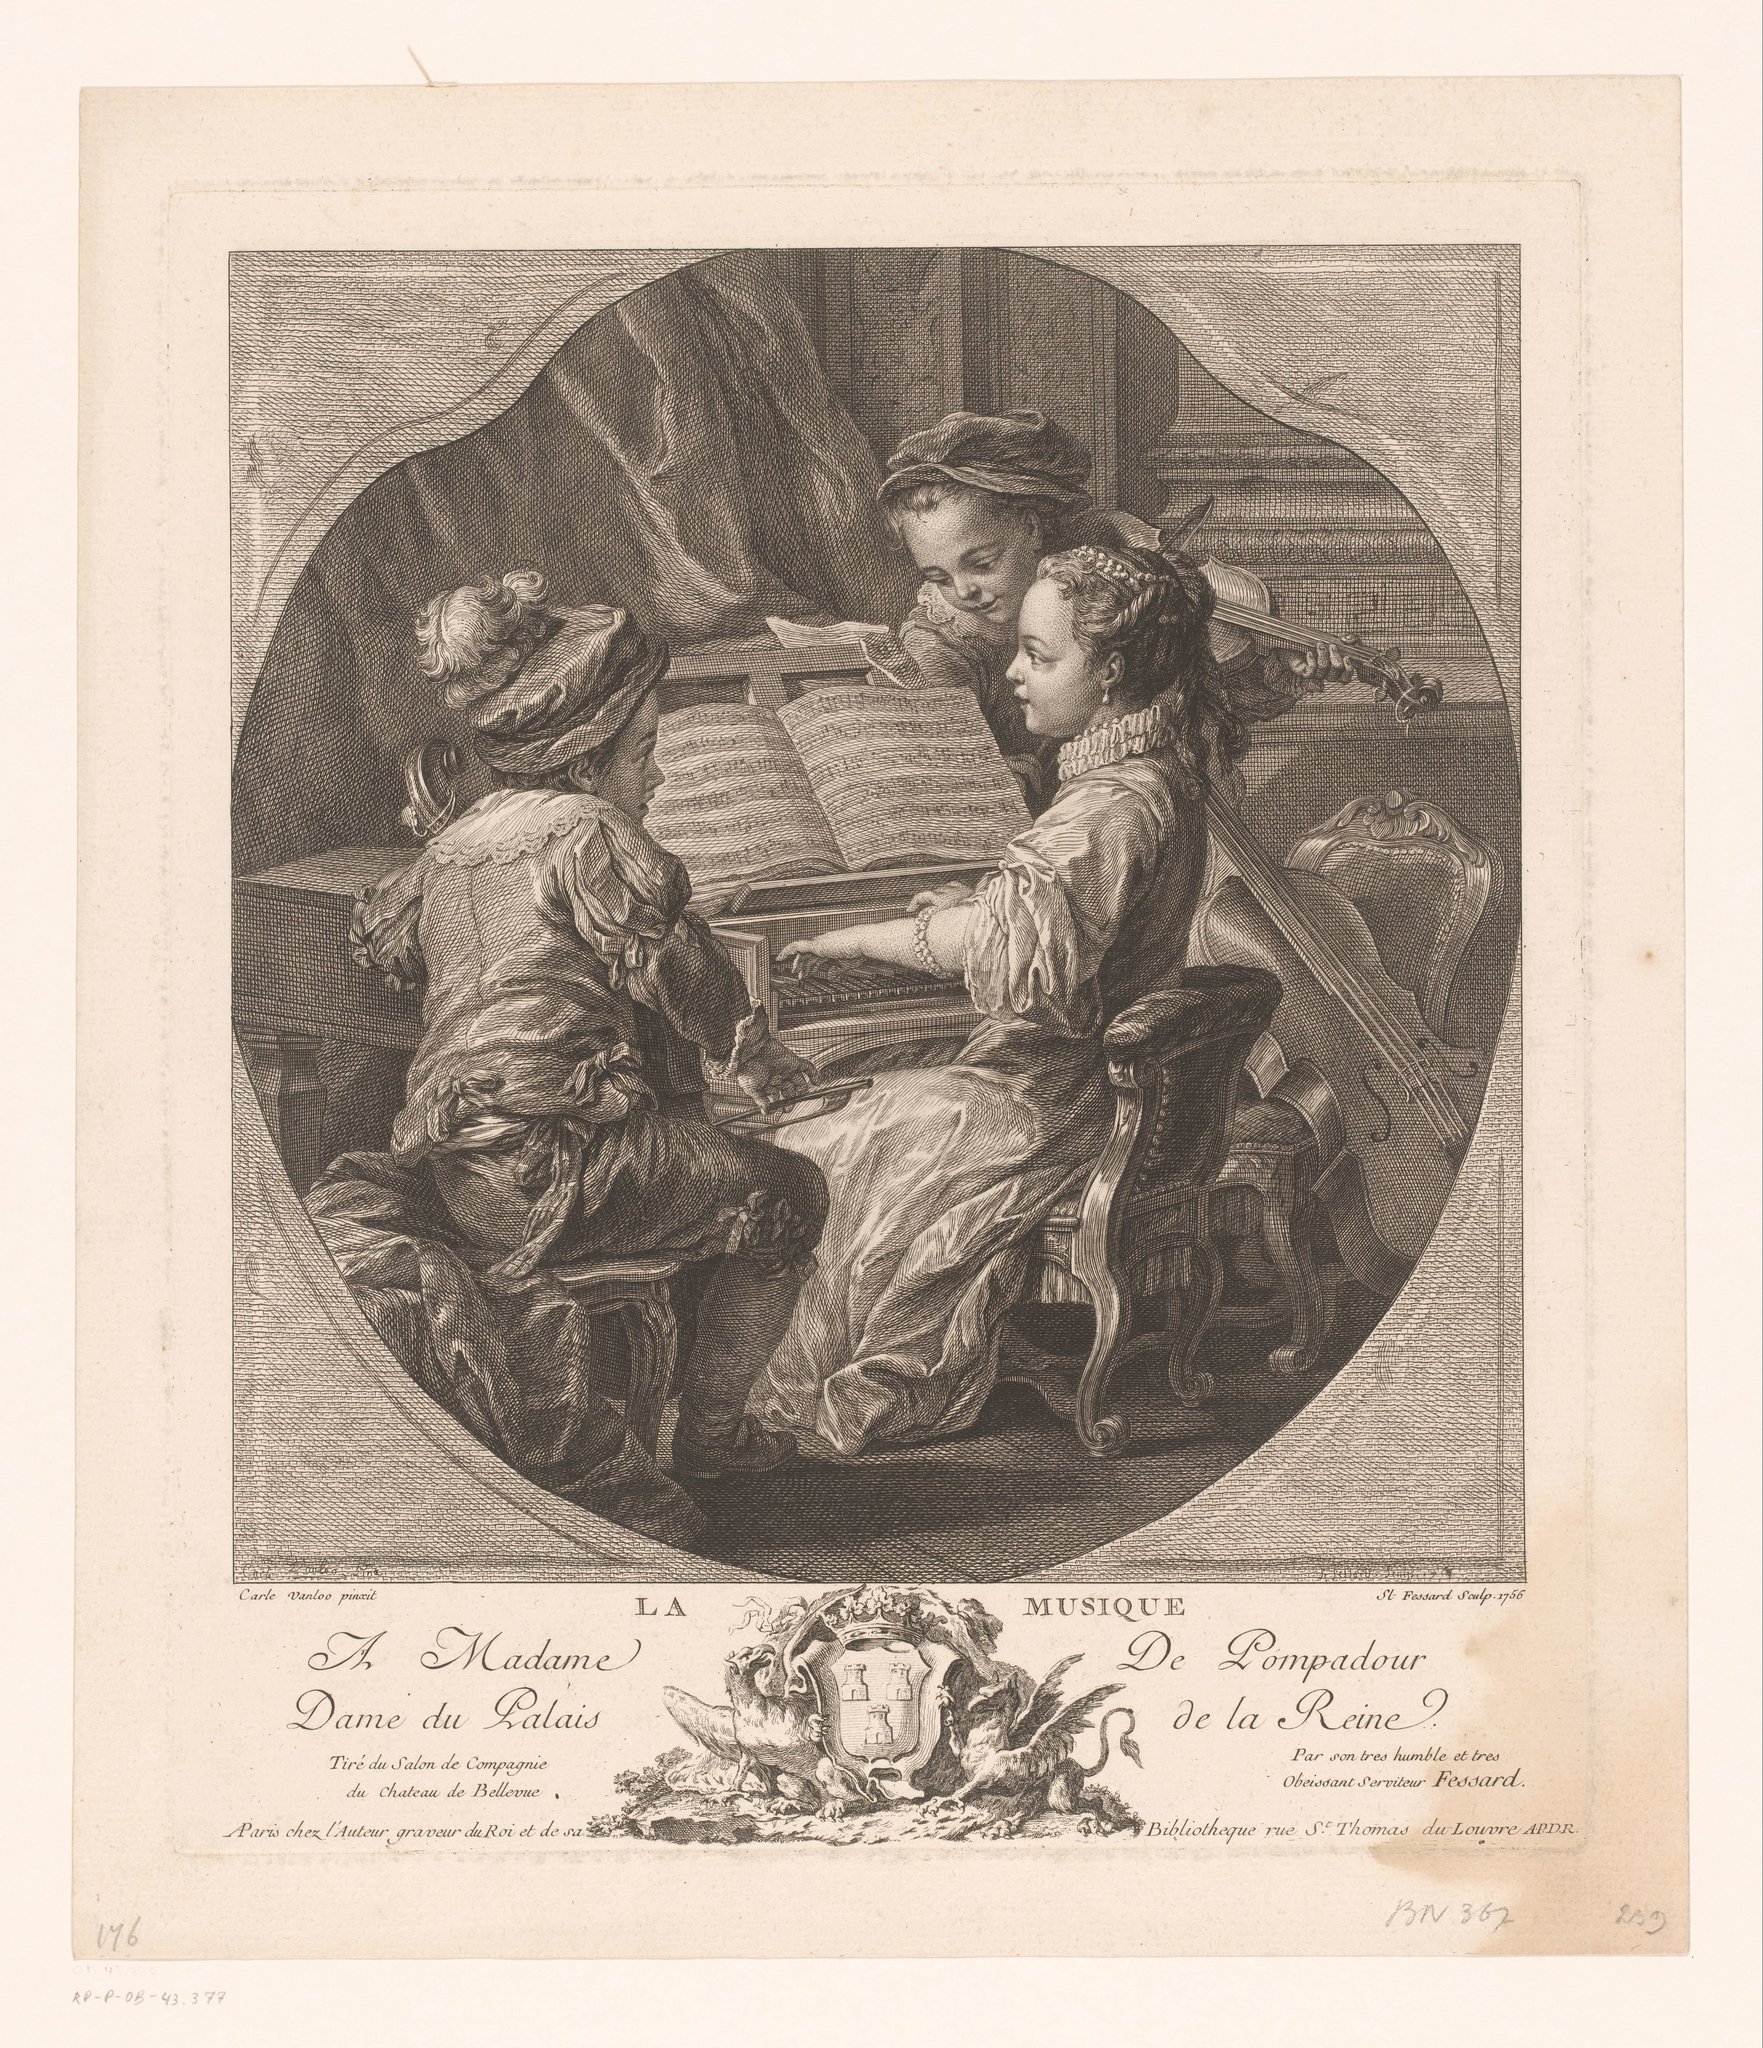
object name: print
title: Personificatie van de muziek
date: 1756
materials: paper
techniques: engraving, etching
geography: france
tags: music, children behaving like adults, armorial bearing, heraldry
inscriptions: collector's mark: Lugt 2228